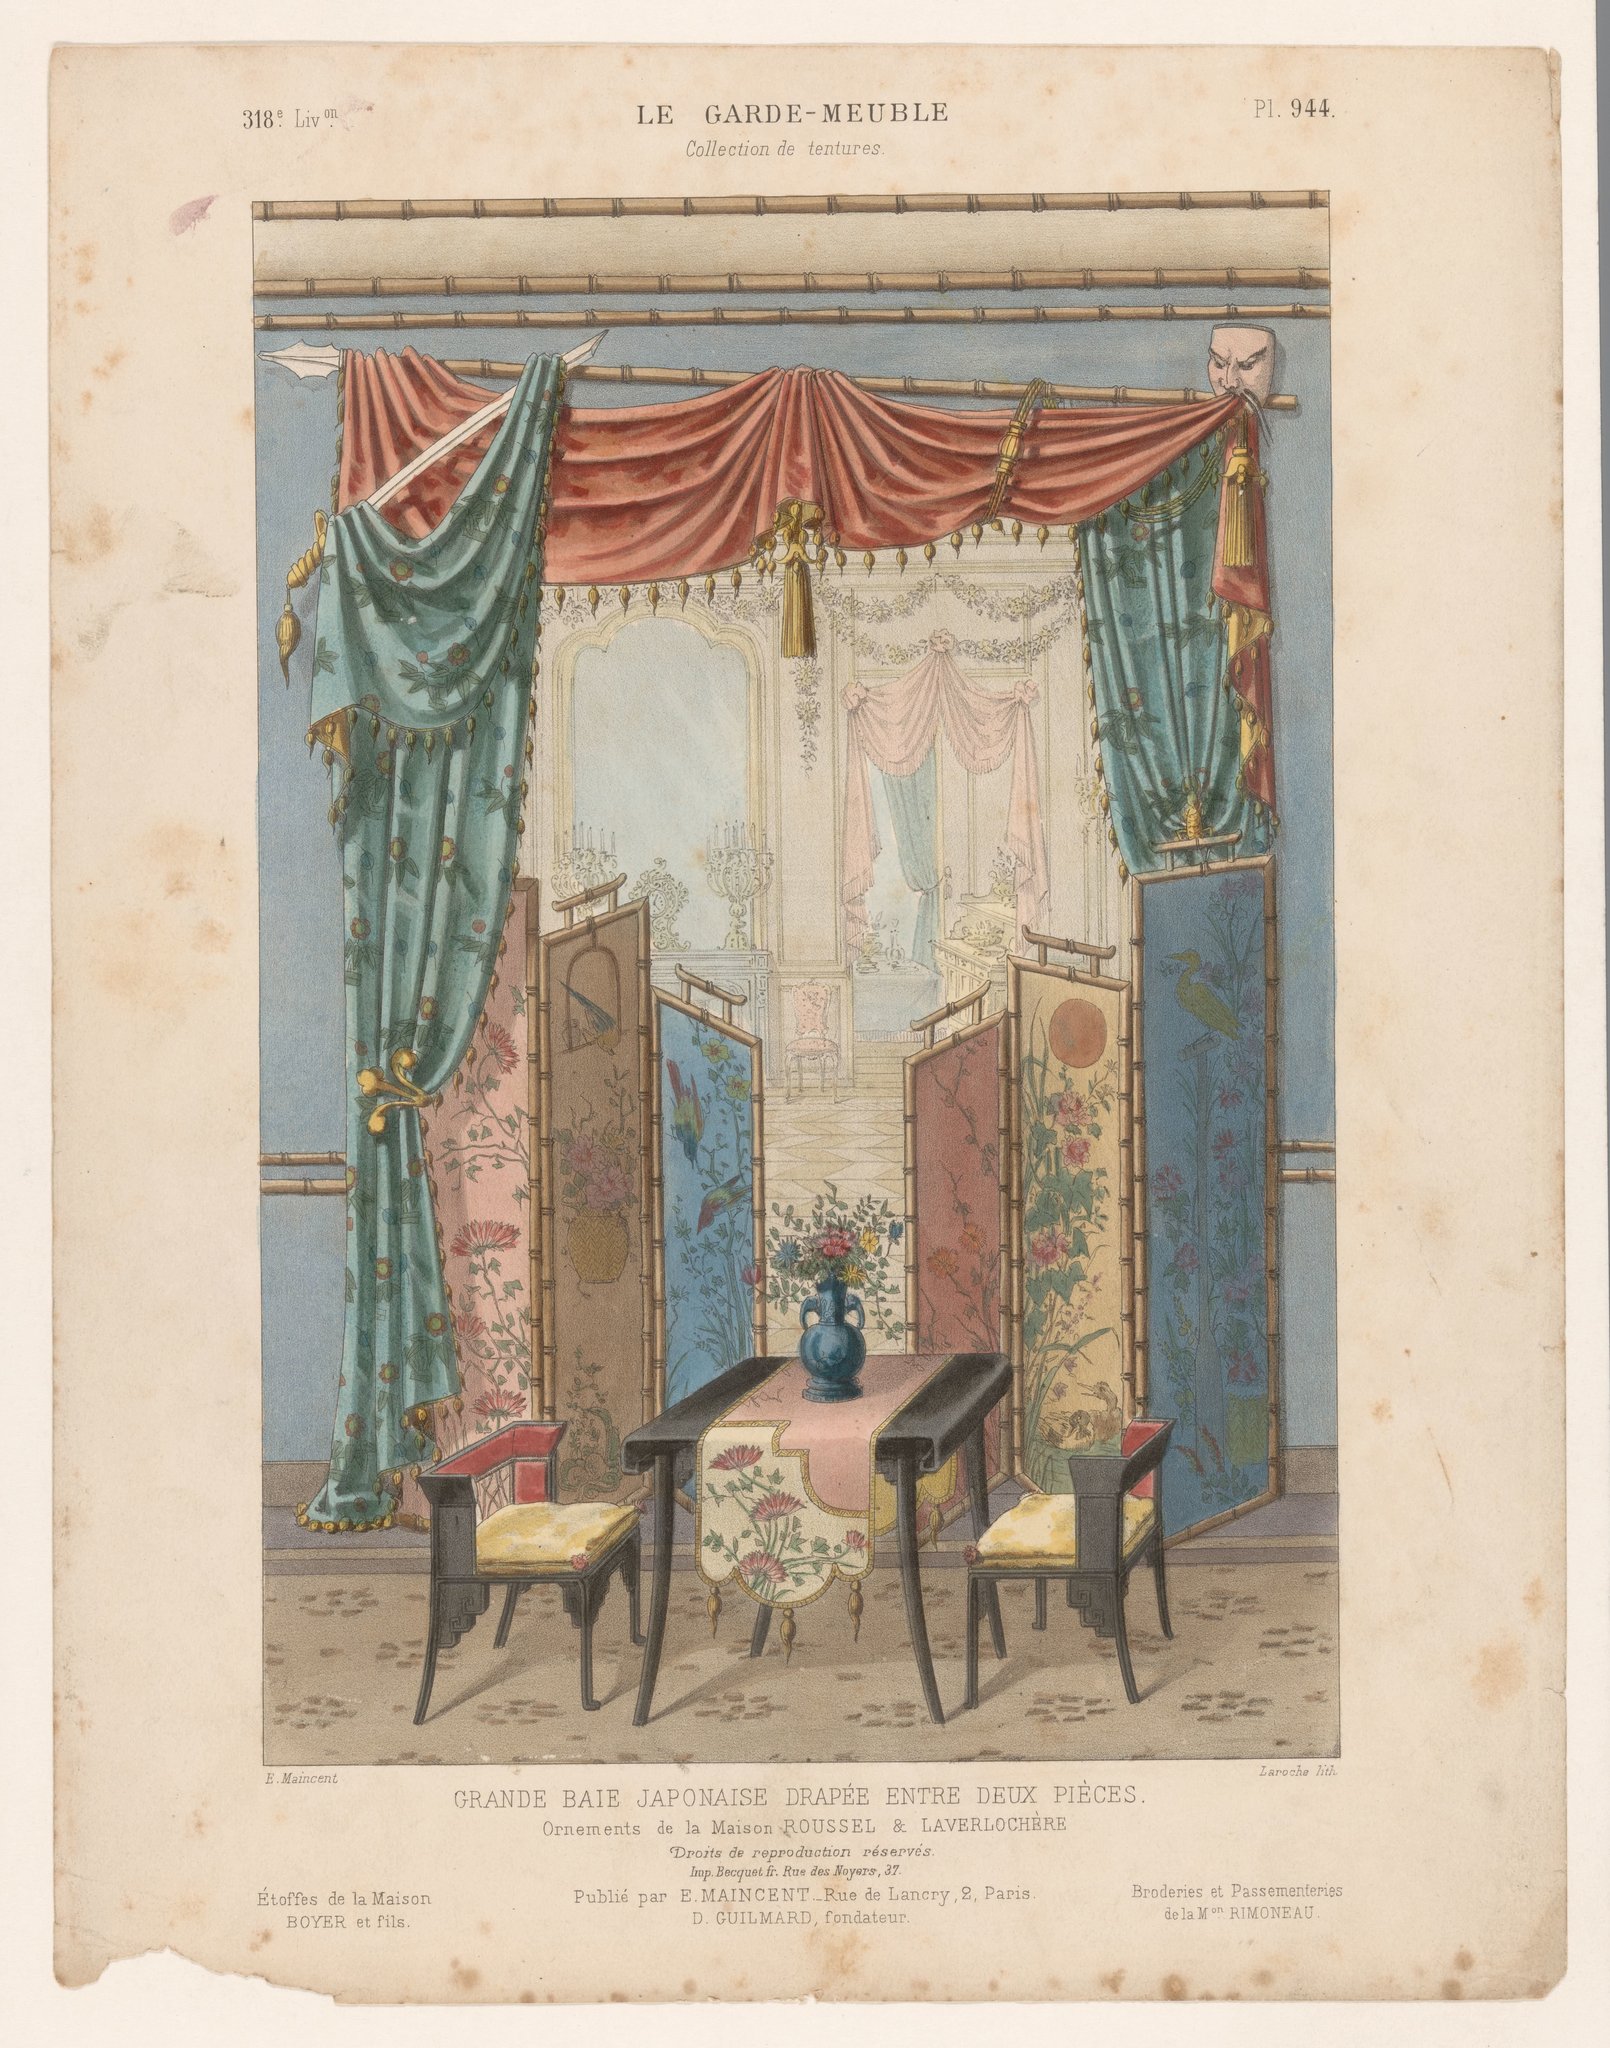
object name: print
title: Grande Baie Japonaise drapée entre deux Pièces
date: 1885-1895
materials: paper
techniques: hand coloring, lithograph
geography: paris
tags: decorations (interior of the house), screen, folding screen, hangings and drapery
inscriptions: : ‘Droits de reproduction réservés.’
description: Grote doorgang tussen twee vertrekken met tafel, stoelen, kamerschermen en gedrapeerde gordijnen in Japanse stijl. Prent uit 318e Livraison.